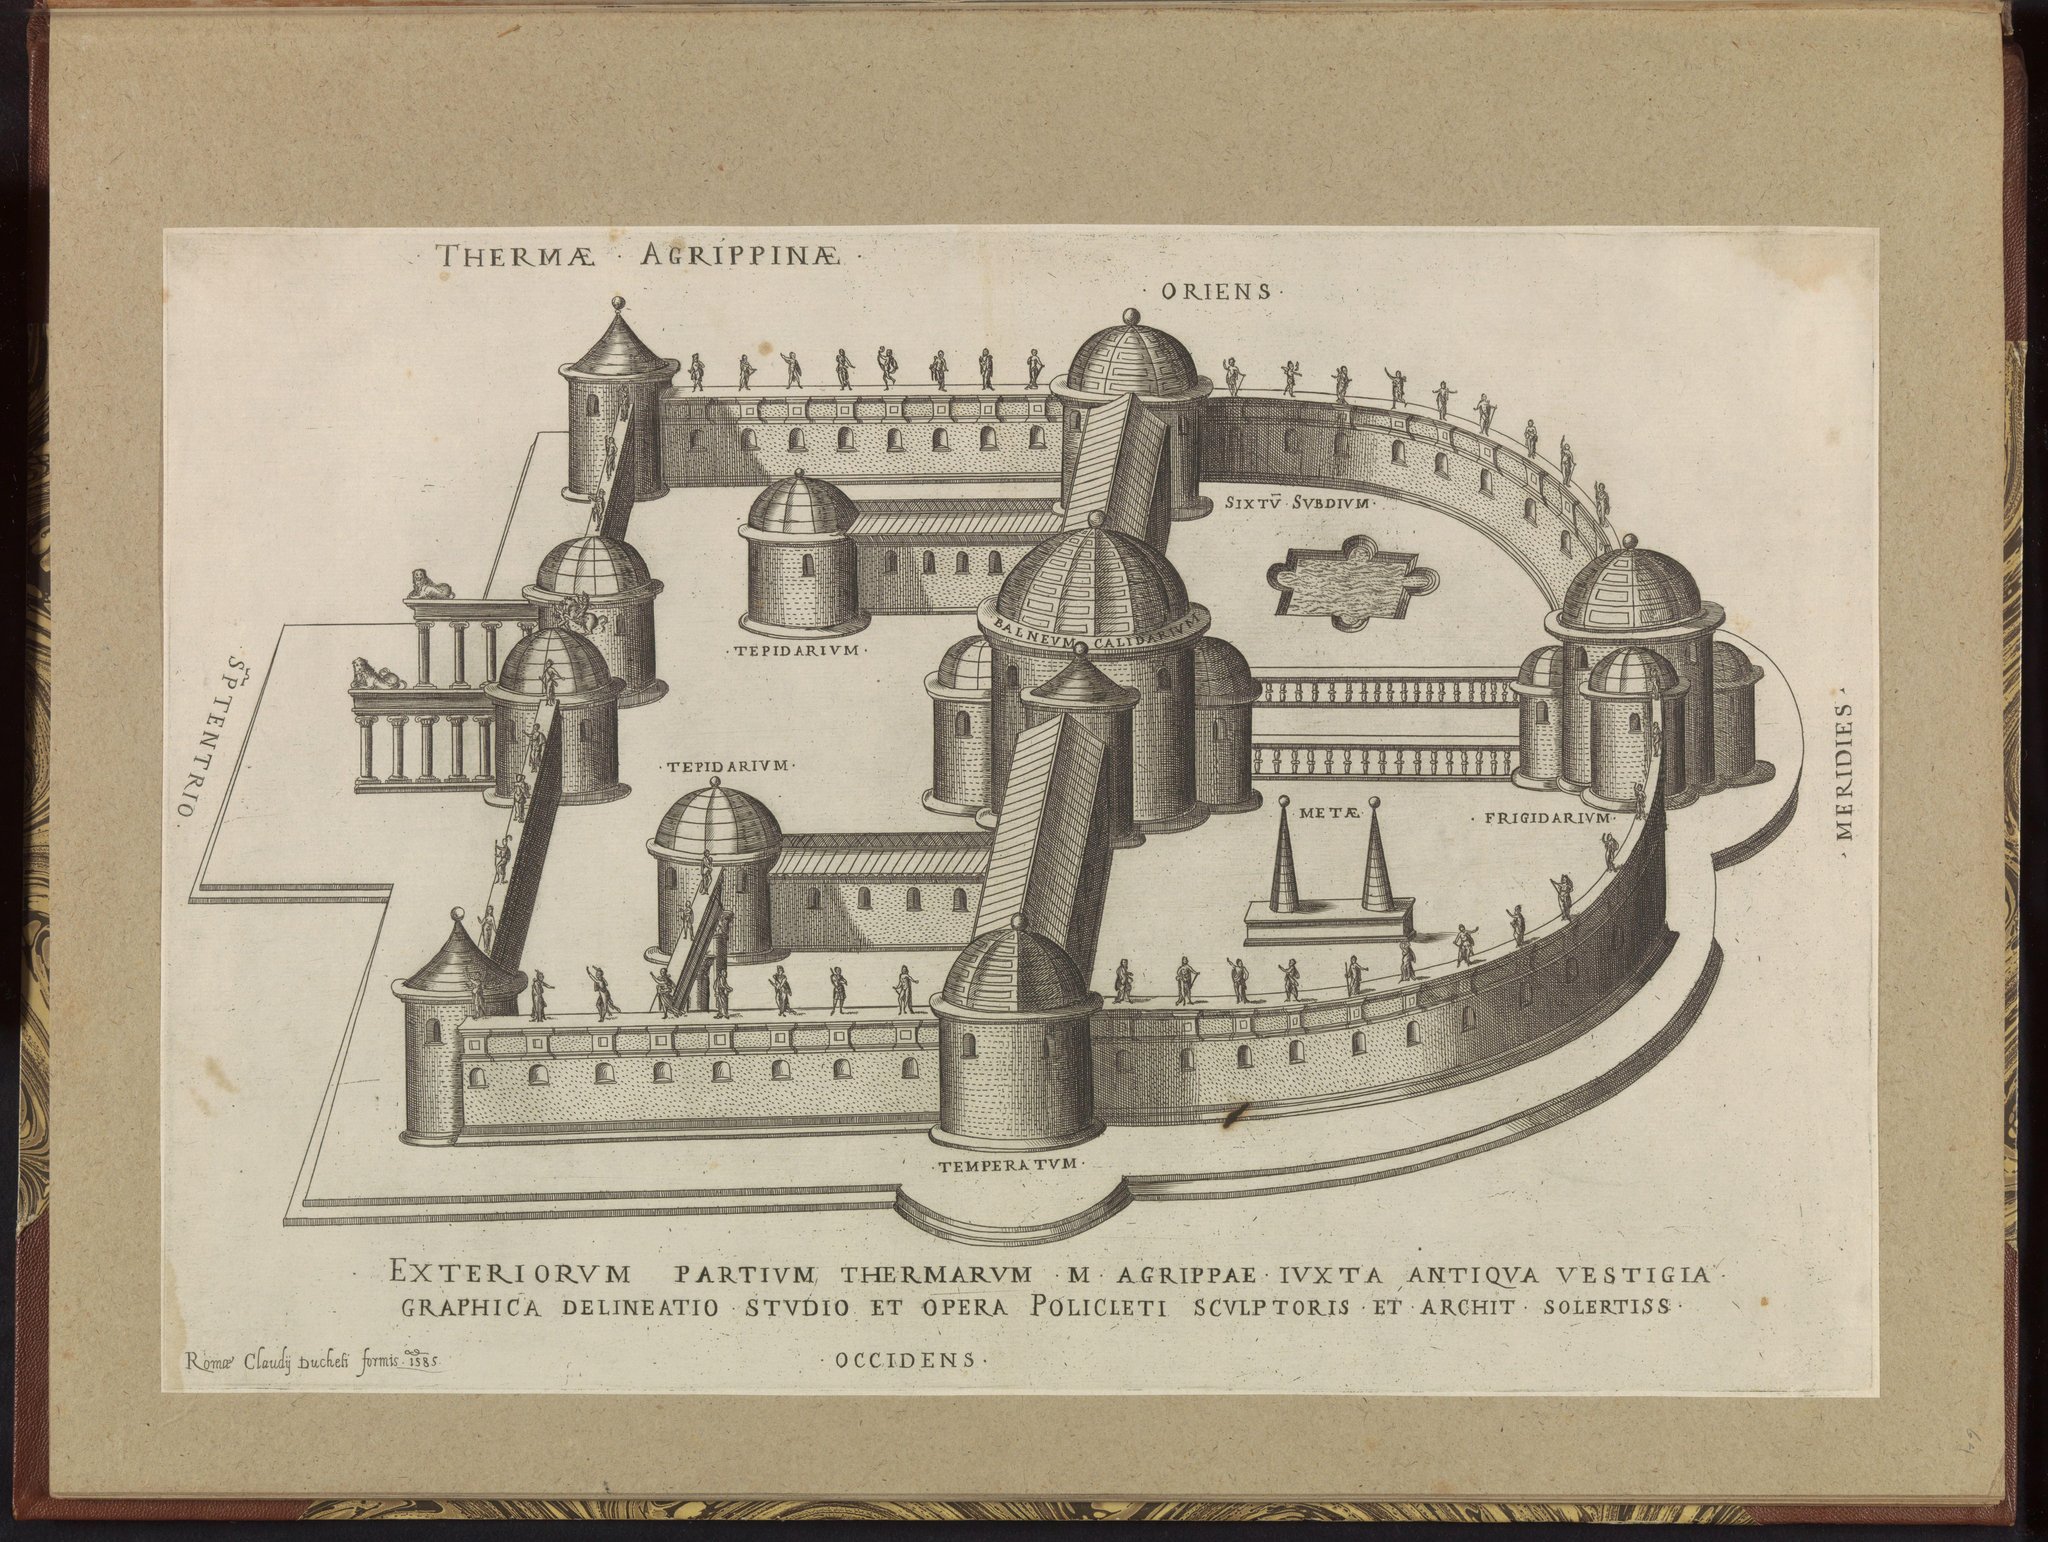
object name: album leaf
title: Speculum Romanae Magnificentiae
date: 1585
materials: paper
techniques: engraving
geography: italy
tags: public baths, representation of real building (either existing or having existed)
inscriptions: date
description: Deze prent behoort tot het prentcorpus dat bekend staat als de ‘Speculum Romanae Magnificentiae’ (‘Spiegel van Romeinse pracht’). Dit corpus, bestaande uit prenten met voorstellingen van kunstwerken en gebouwen uit het antieke en het moderne Rome, vond zijn oorsprong bij uitgevers Antonio Salamanca en Antonio Lafreri. Deze twee buitenlandse uitgevers bundelden hun krachten te Rome in de periode 1553-1563. Hun prenten werden al snel razend populair bij toeristen en verzamelaars, die de prenten individueel of in grote groepen aanschaften. Grote groepen Speculum-prenten werden vaak op aanvraag samengebonden in albums. Er zijn verschillende Speculum-albums overgeleverd die allemaal verschillen van inhoud. Tussen 1573 en 1577 gaf Antonio Lafreri een speciale titelpagina uit (met de titel ‘Speculum Romanae Magnificentiae’) die mensen voor hun verzamelingen konden voegen. Het overlijden van Lafreri in 1577 betekende niet het einde van het corpus. Een groot deel van de koperplaten ging over op Claudio en Stefano Duchetti. De rest raakte verspreid over verschillende andere uitgevers. De populariteit van de Speculum-prenten wist nog geruime periode uitgevers te inspireren tot het laten maken van kopieën en het toevoegen van nieuwe prenten aan het corpus.